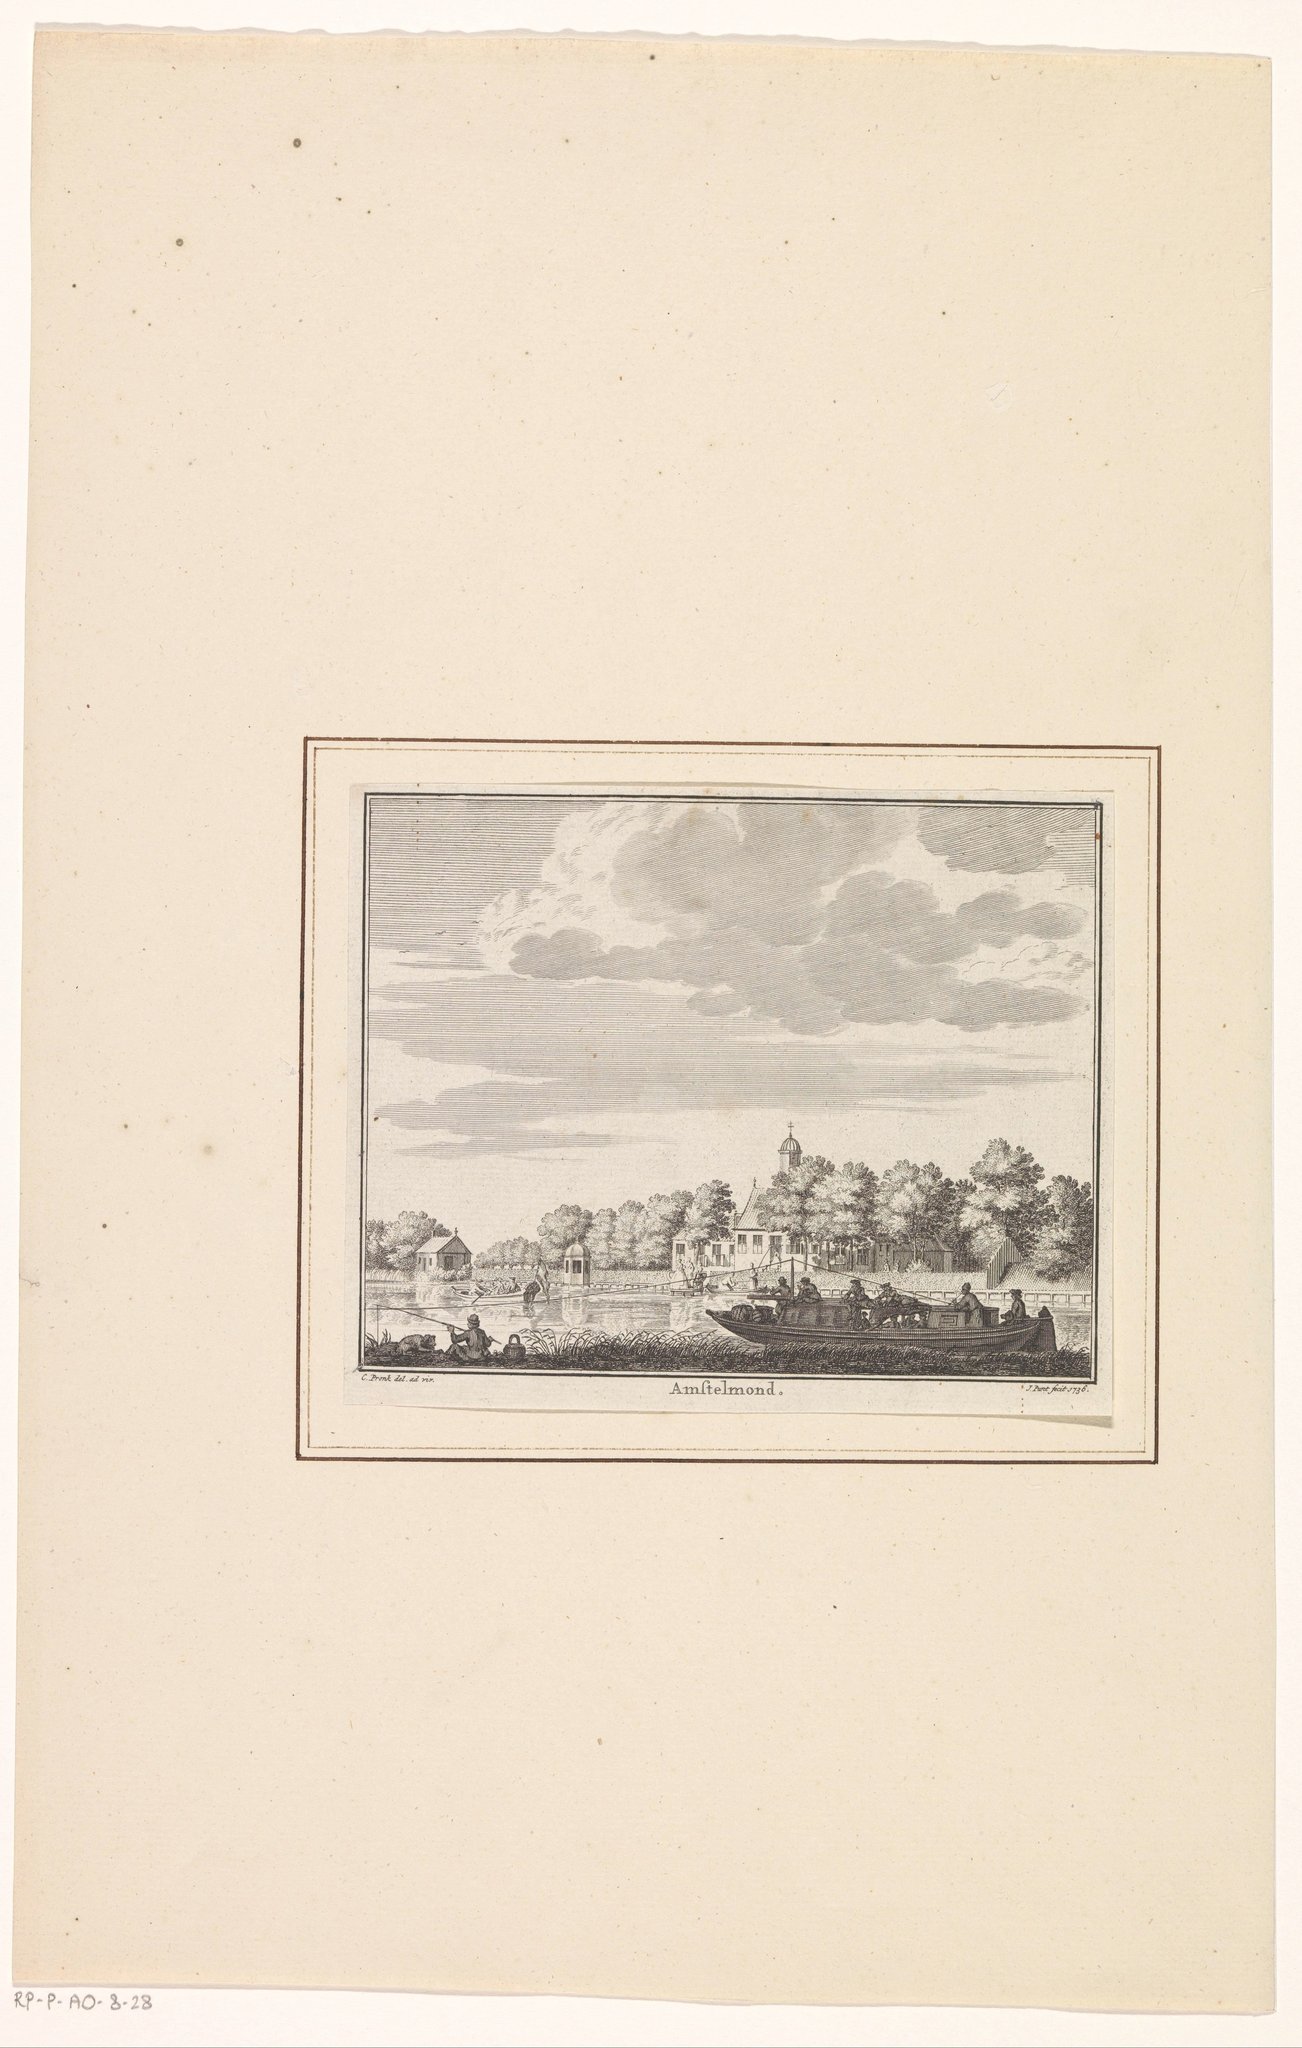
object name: print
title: Amstelmond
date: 1736-1773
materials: paper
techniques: engraving, etching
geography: amsterdam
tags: river, country-house, boat propelled by man or animal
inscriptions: collector's mark: Lugt 195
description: Prent ook gebruikt in: Schoemaker, Gerrit ed. Daniel Willinks Amstellandsche Arkadia, of beschryving van de gelegenheit, toestant en gebeurtenissen van Amstellandt, met deszelfs onderhoorige dorpen, heerlykheden, ambachten, lusthoven, wateren, enz. (…). 2 delen. 1e druk. Amsterdam: Arend van Huyssteen, 1737, dl. 1, p. 146. Of in: Schoemaker, Gerrit ed. Daniel Willinks Amstellandsche Arkadia, of beschryving van de gelegenheit, toestant en gebeurtenissen van Amstellandt, met deszelfs onderhoorige dorpen, heerlykheden, ambachten, lusthoven, wateren, enz. (…). 2 delen. 2e druk. Utrecht: Samuel de Waal, 1773, dl. 1, p. 138.